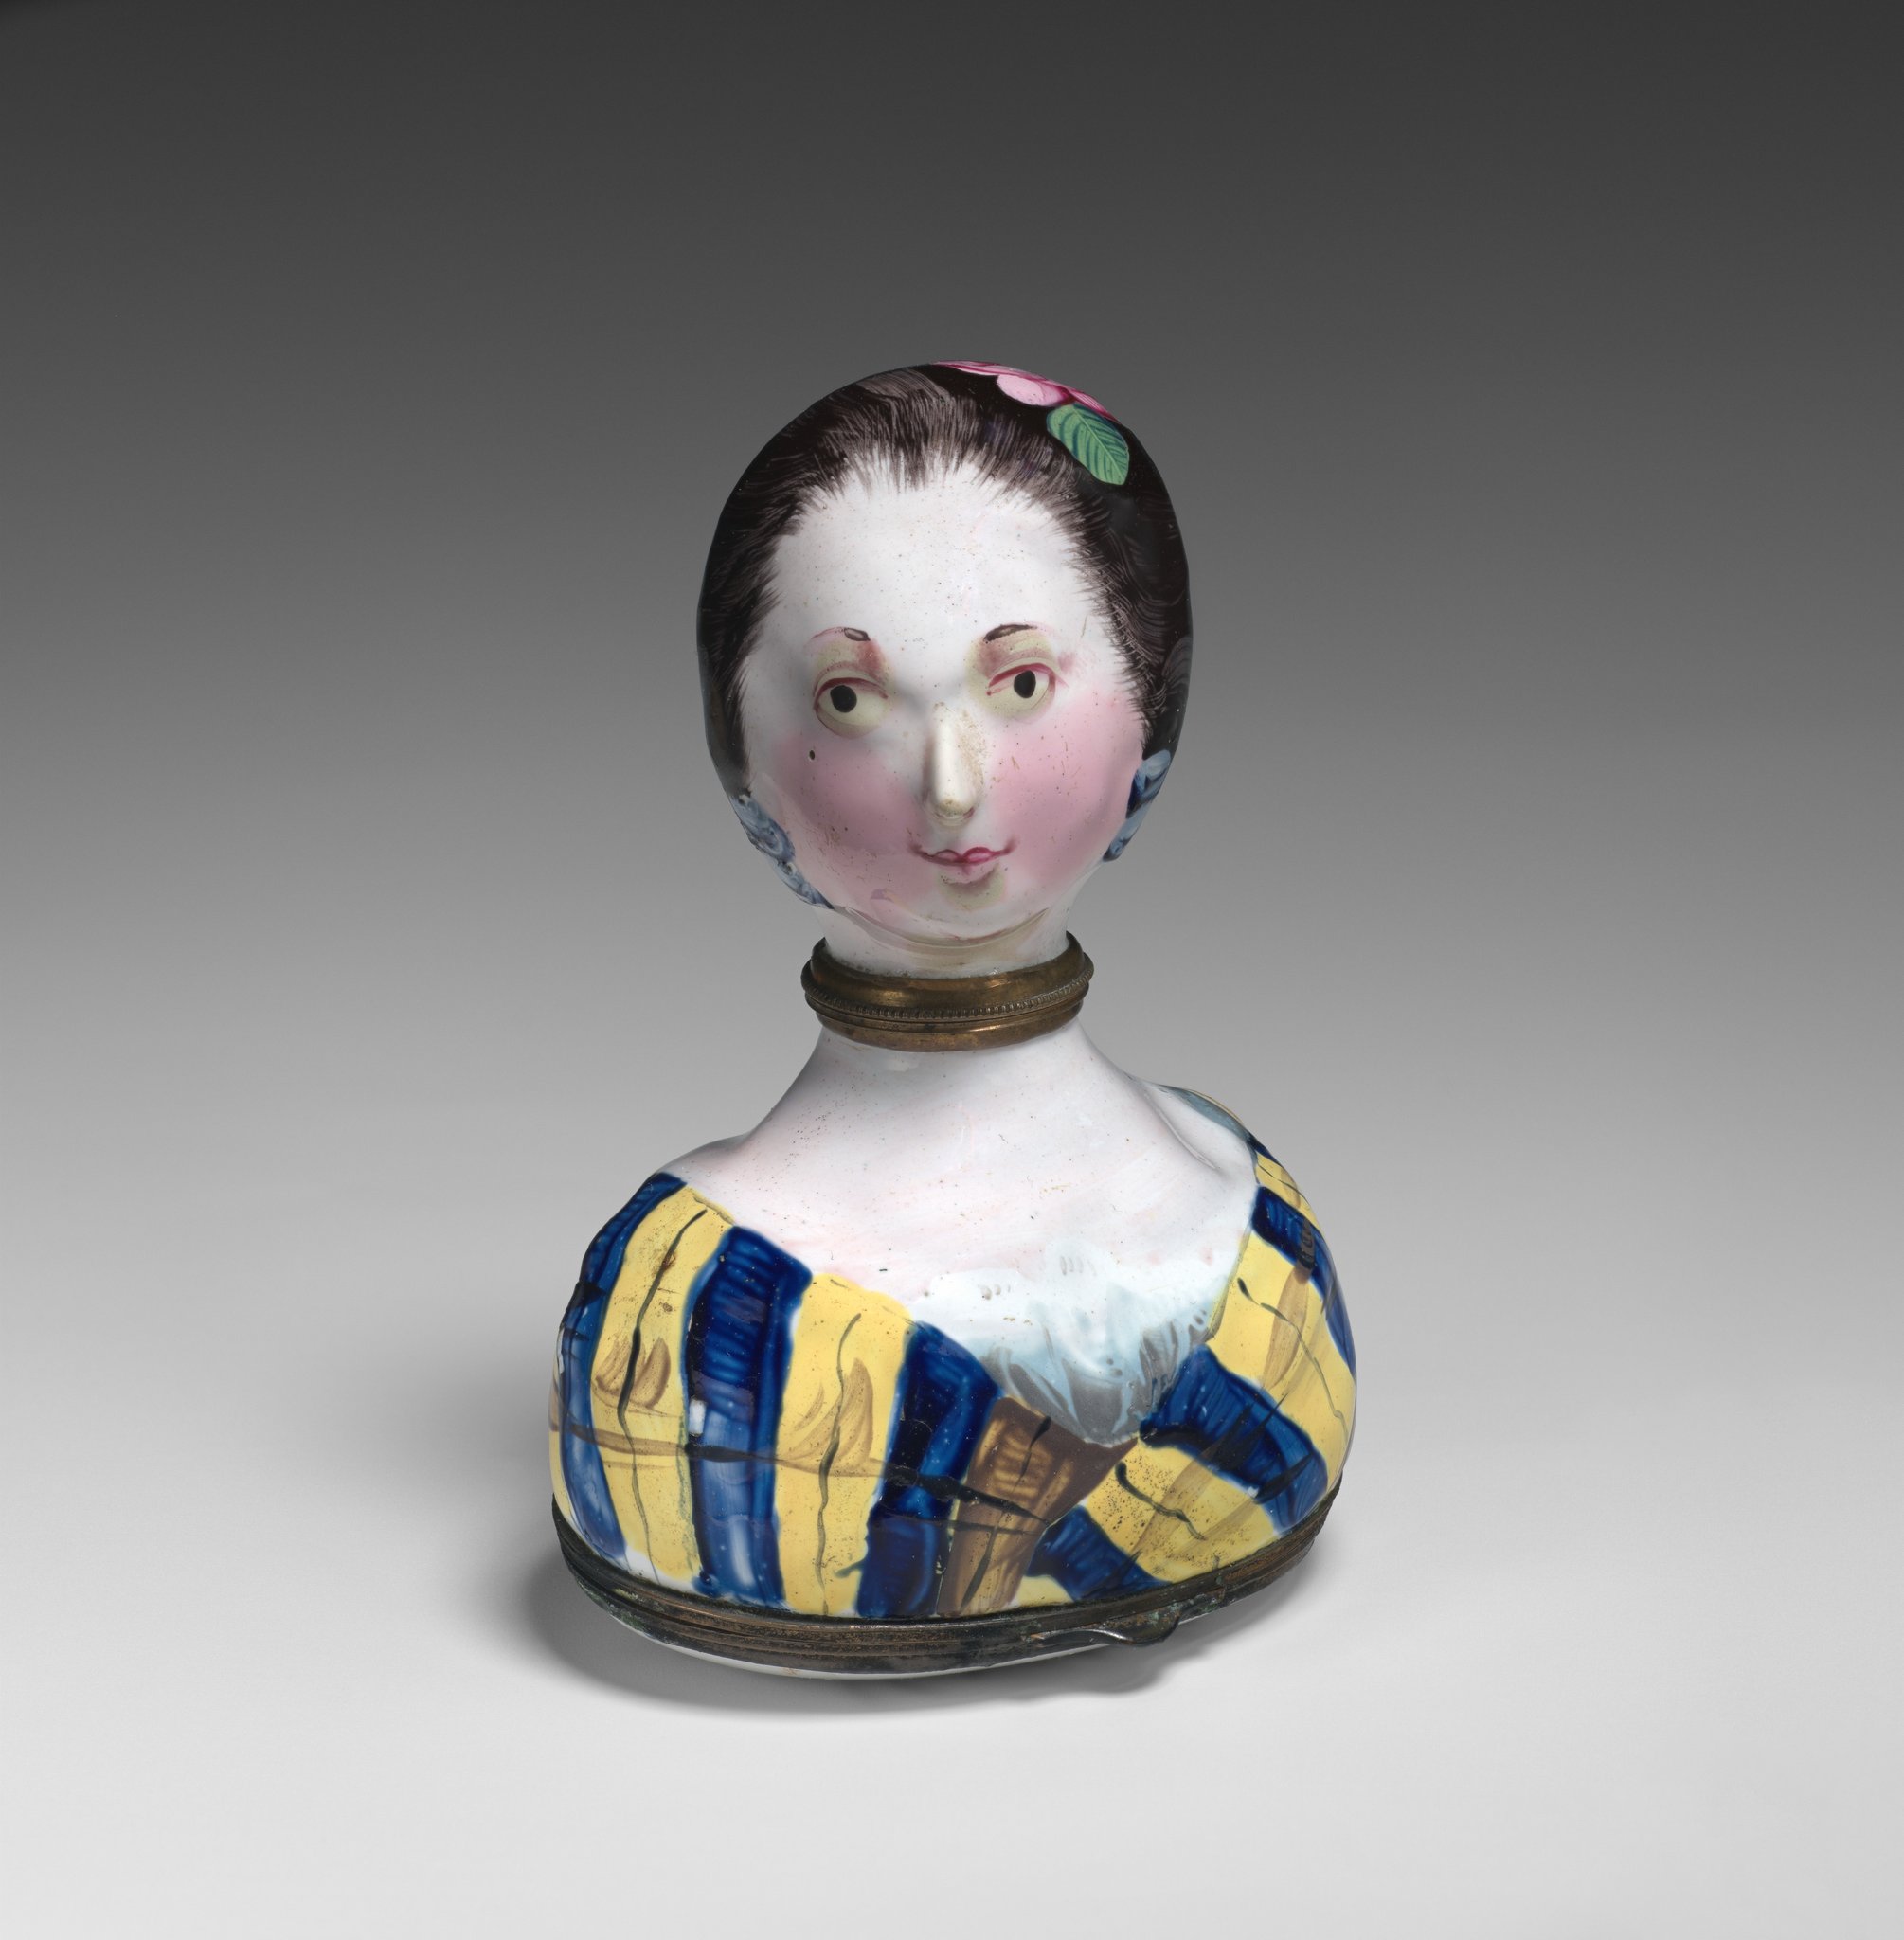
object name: bonbonnière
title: Bust of a woman bonbonnière and scent bottle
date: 1775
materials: copper, enamel, glass